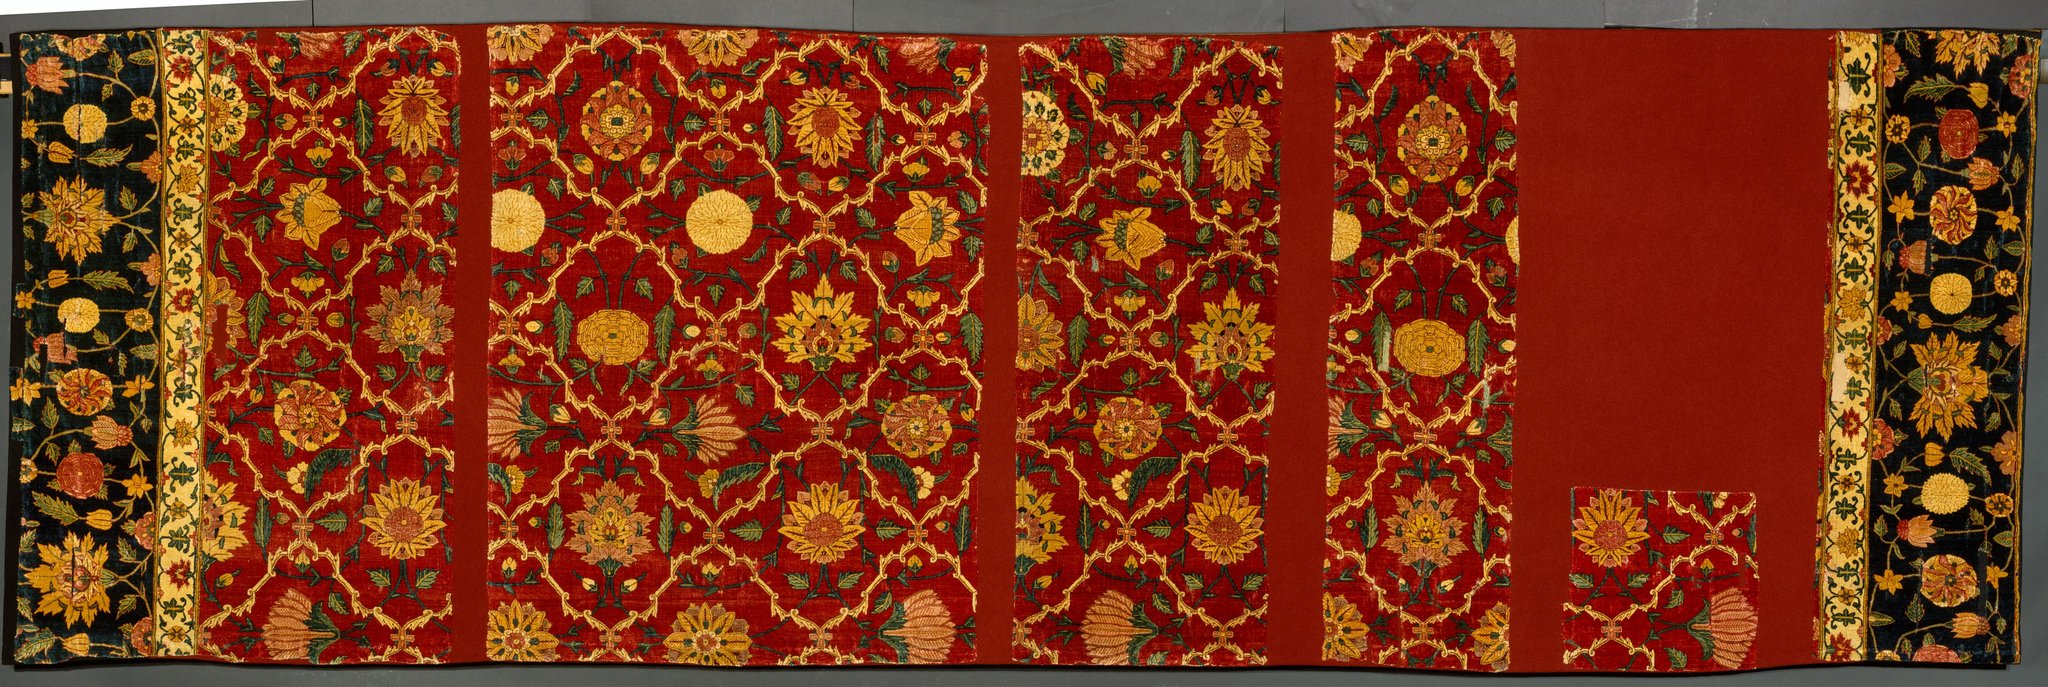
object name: carpet fragment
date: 1650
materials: silk, wool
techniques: asymmetrically knotted pile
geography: india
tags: flowers